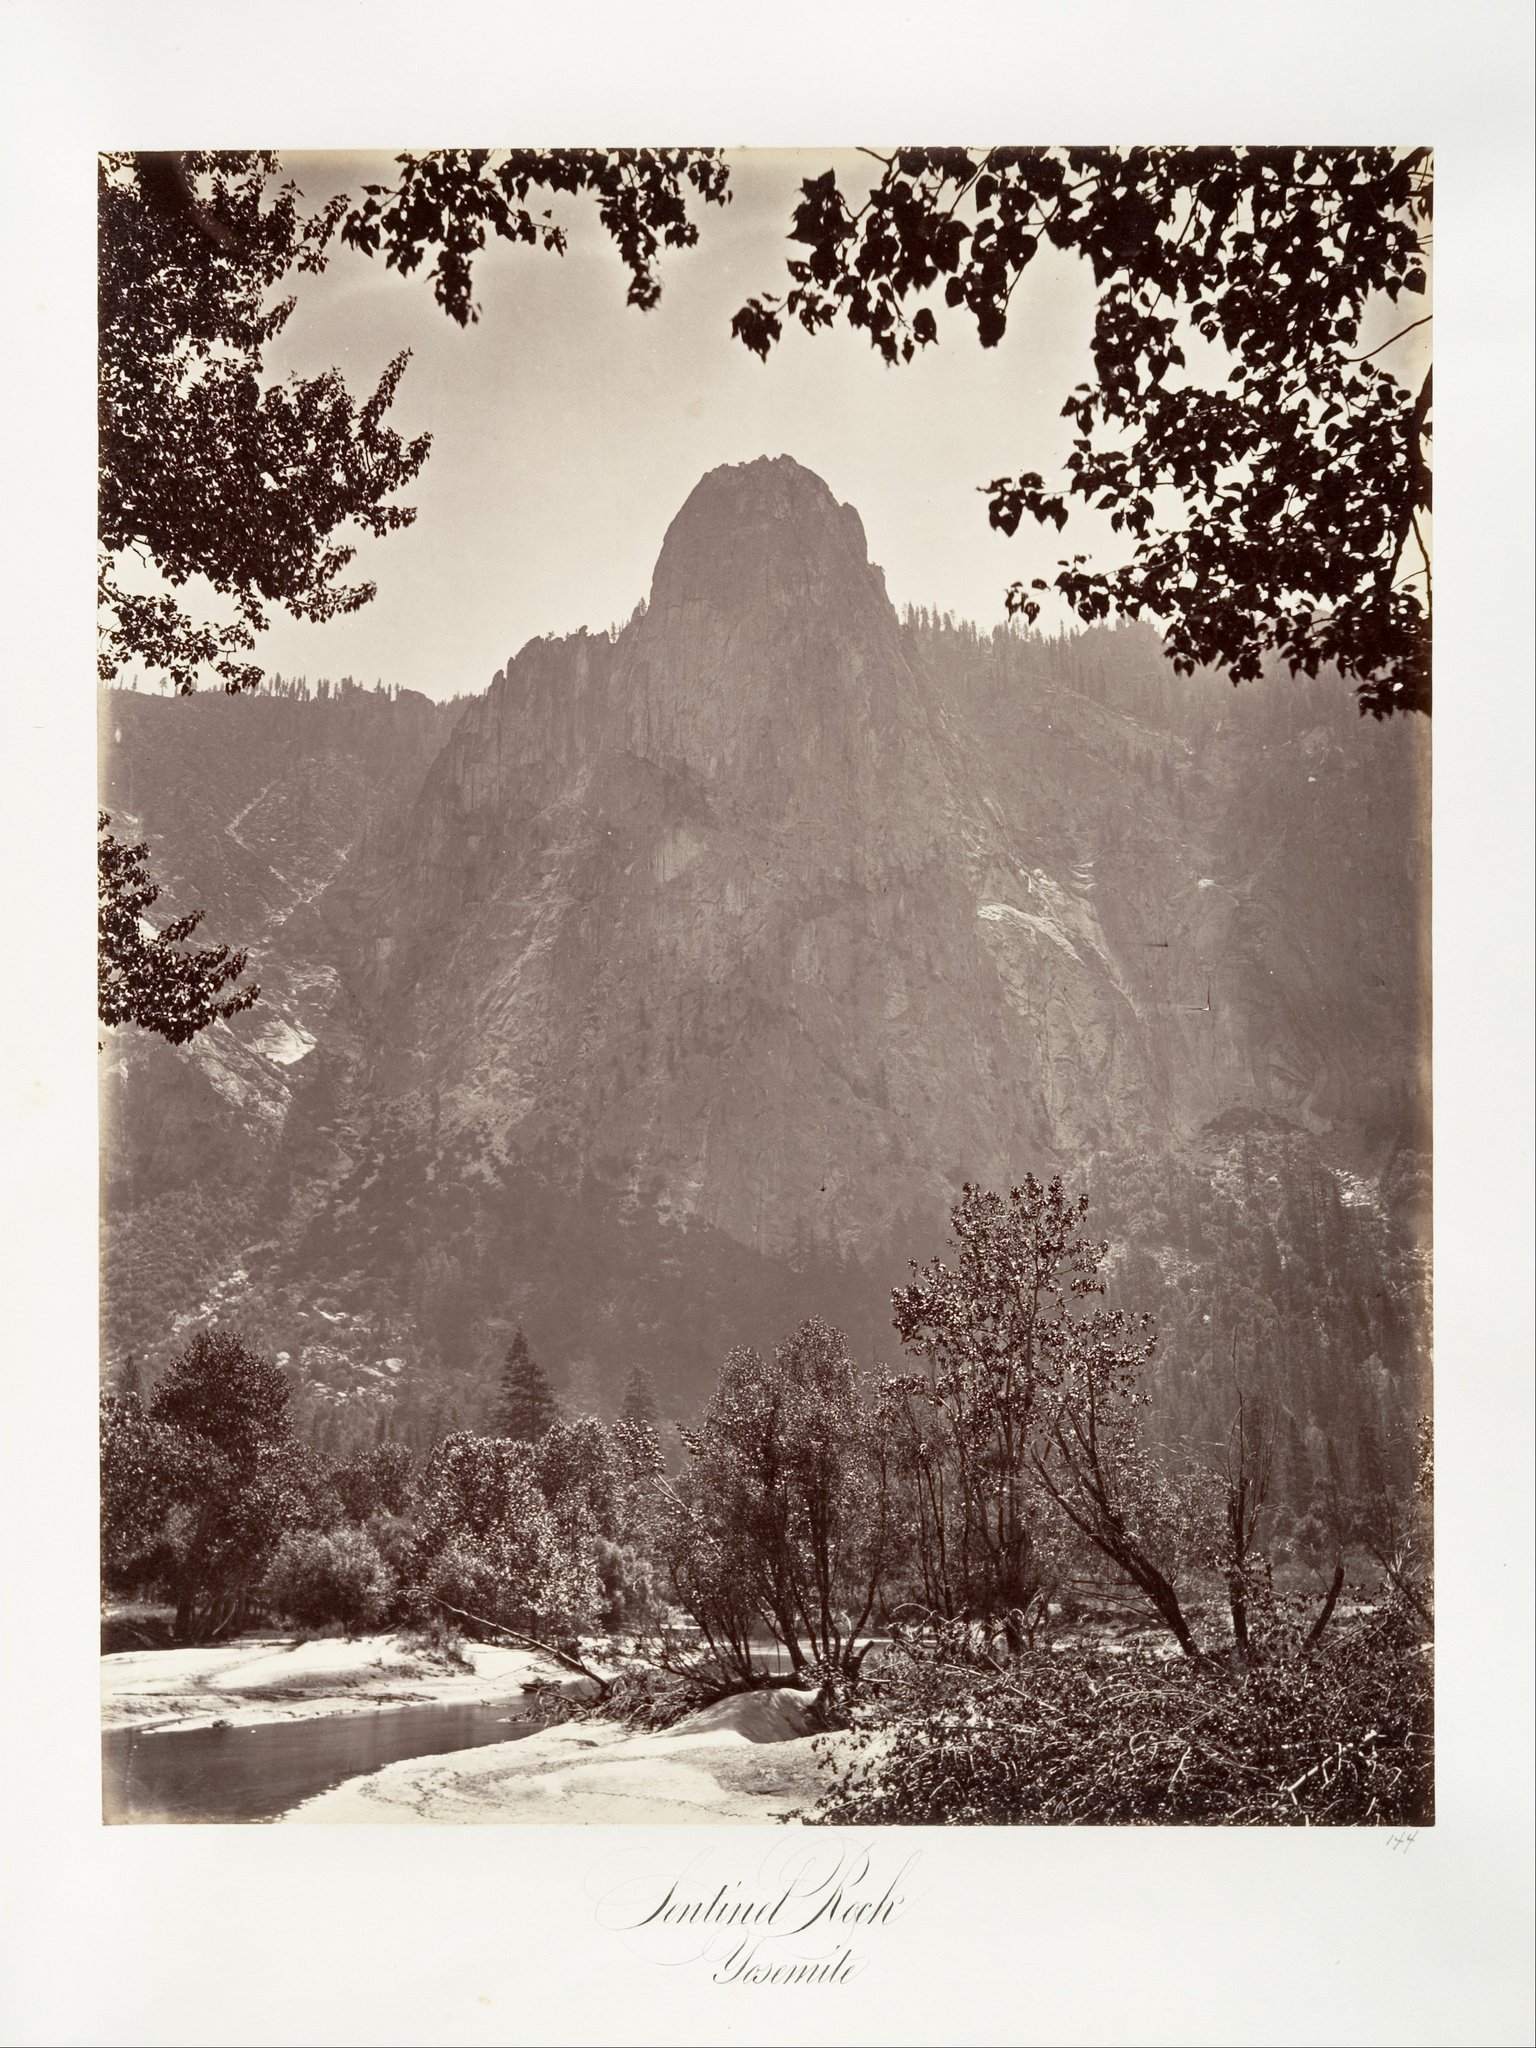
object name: photograph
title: Sentinel Rock, Yosemite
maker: carleton e. watkins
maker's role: artist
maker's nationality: american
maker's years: 1829-1916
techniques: albumen silver print, glass negative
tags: mountains,landscapes